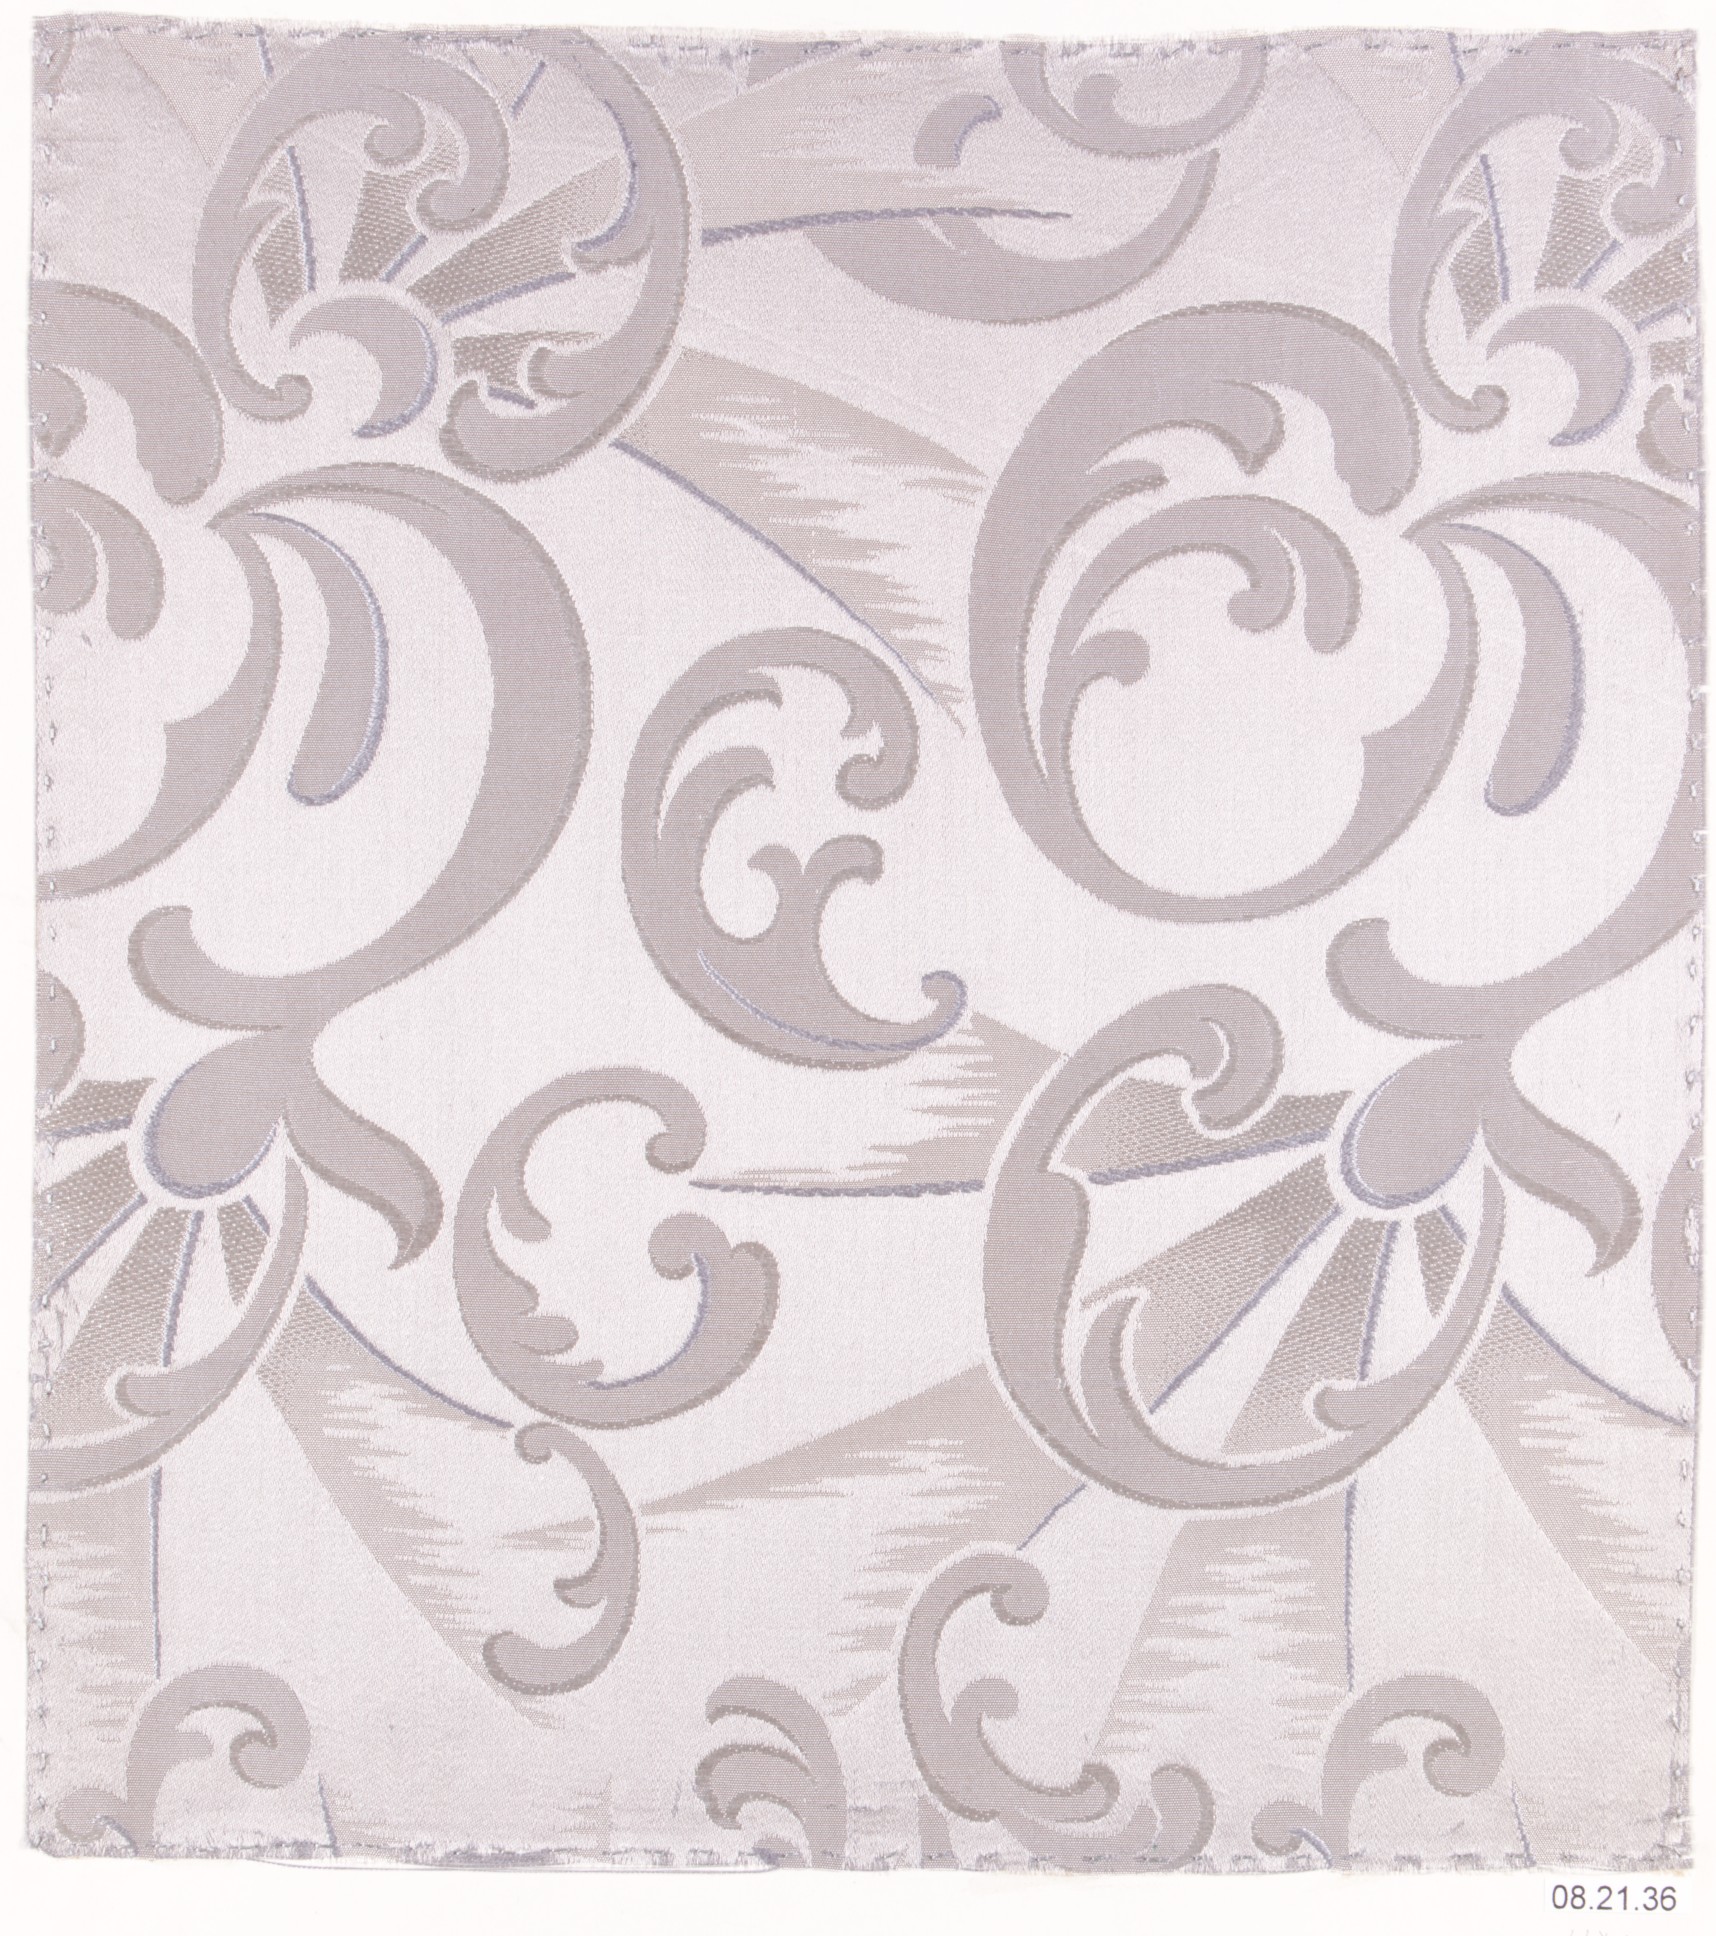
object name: textile sample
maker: Anonymous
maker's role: designer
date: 1900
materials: silk